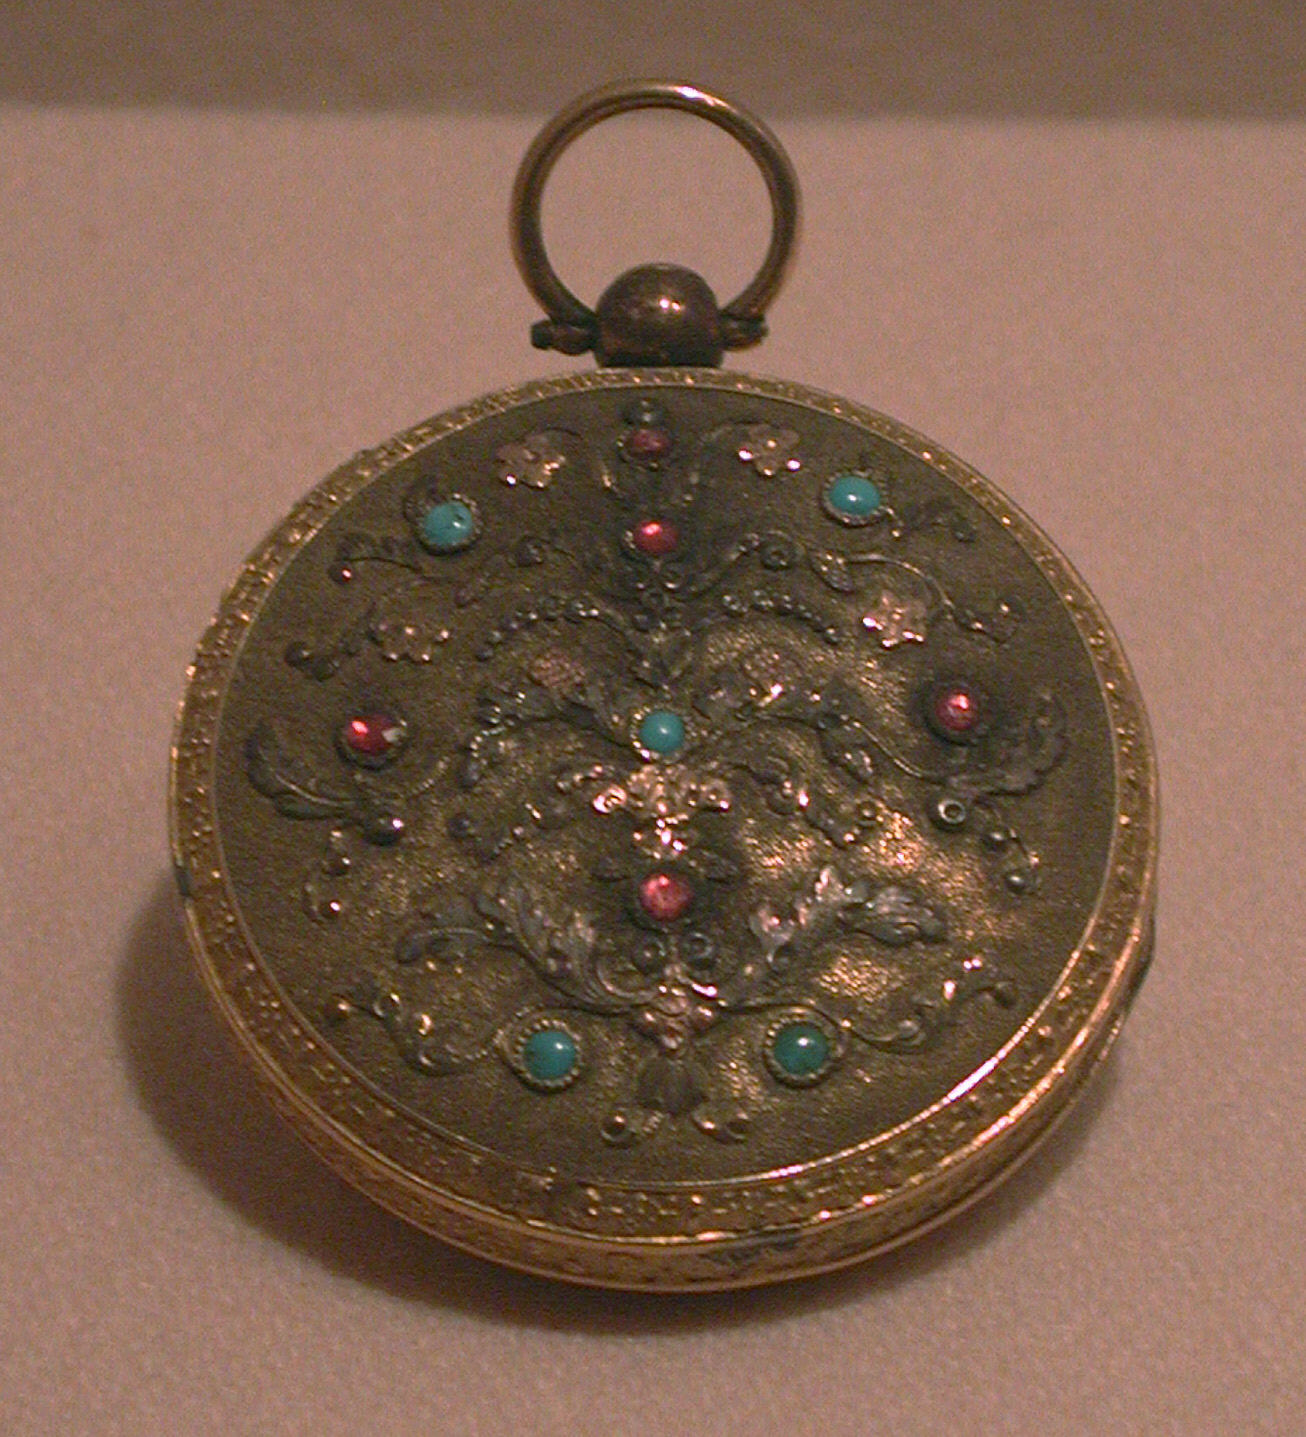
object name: watch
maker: firm of esquivillon frères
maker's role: maker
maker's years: 1795-1805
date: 1800-1820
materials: enamel, gold, steel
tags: leaves